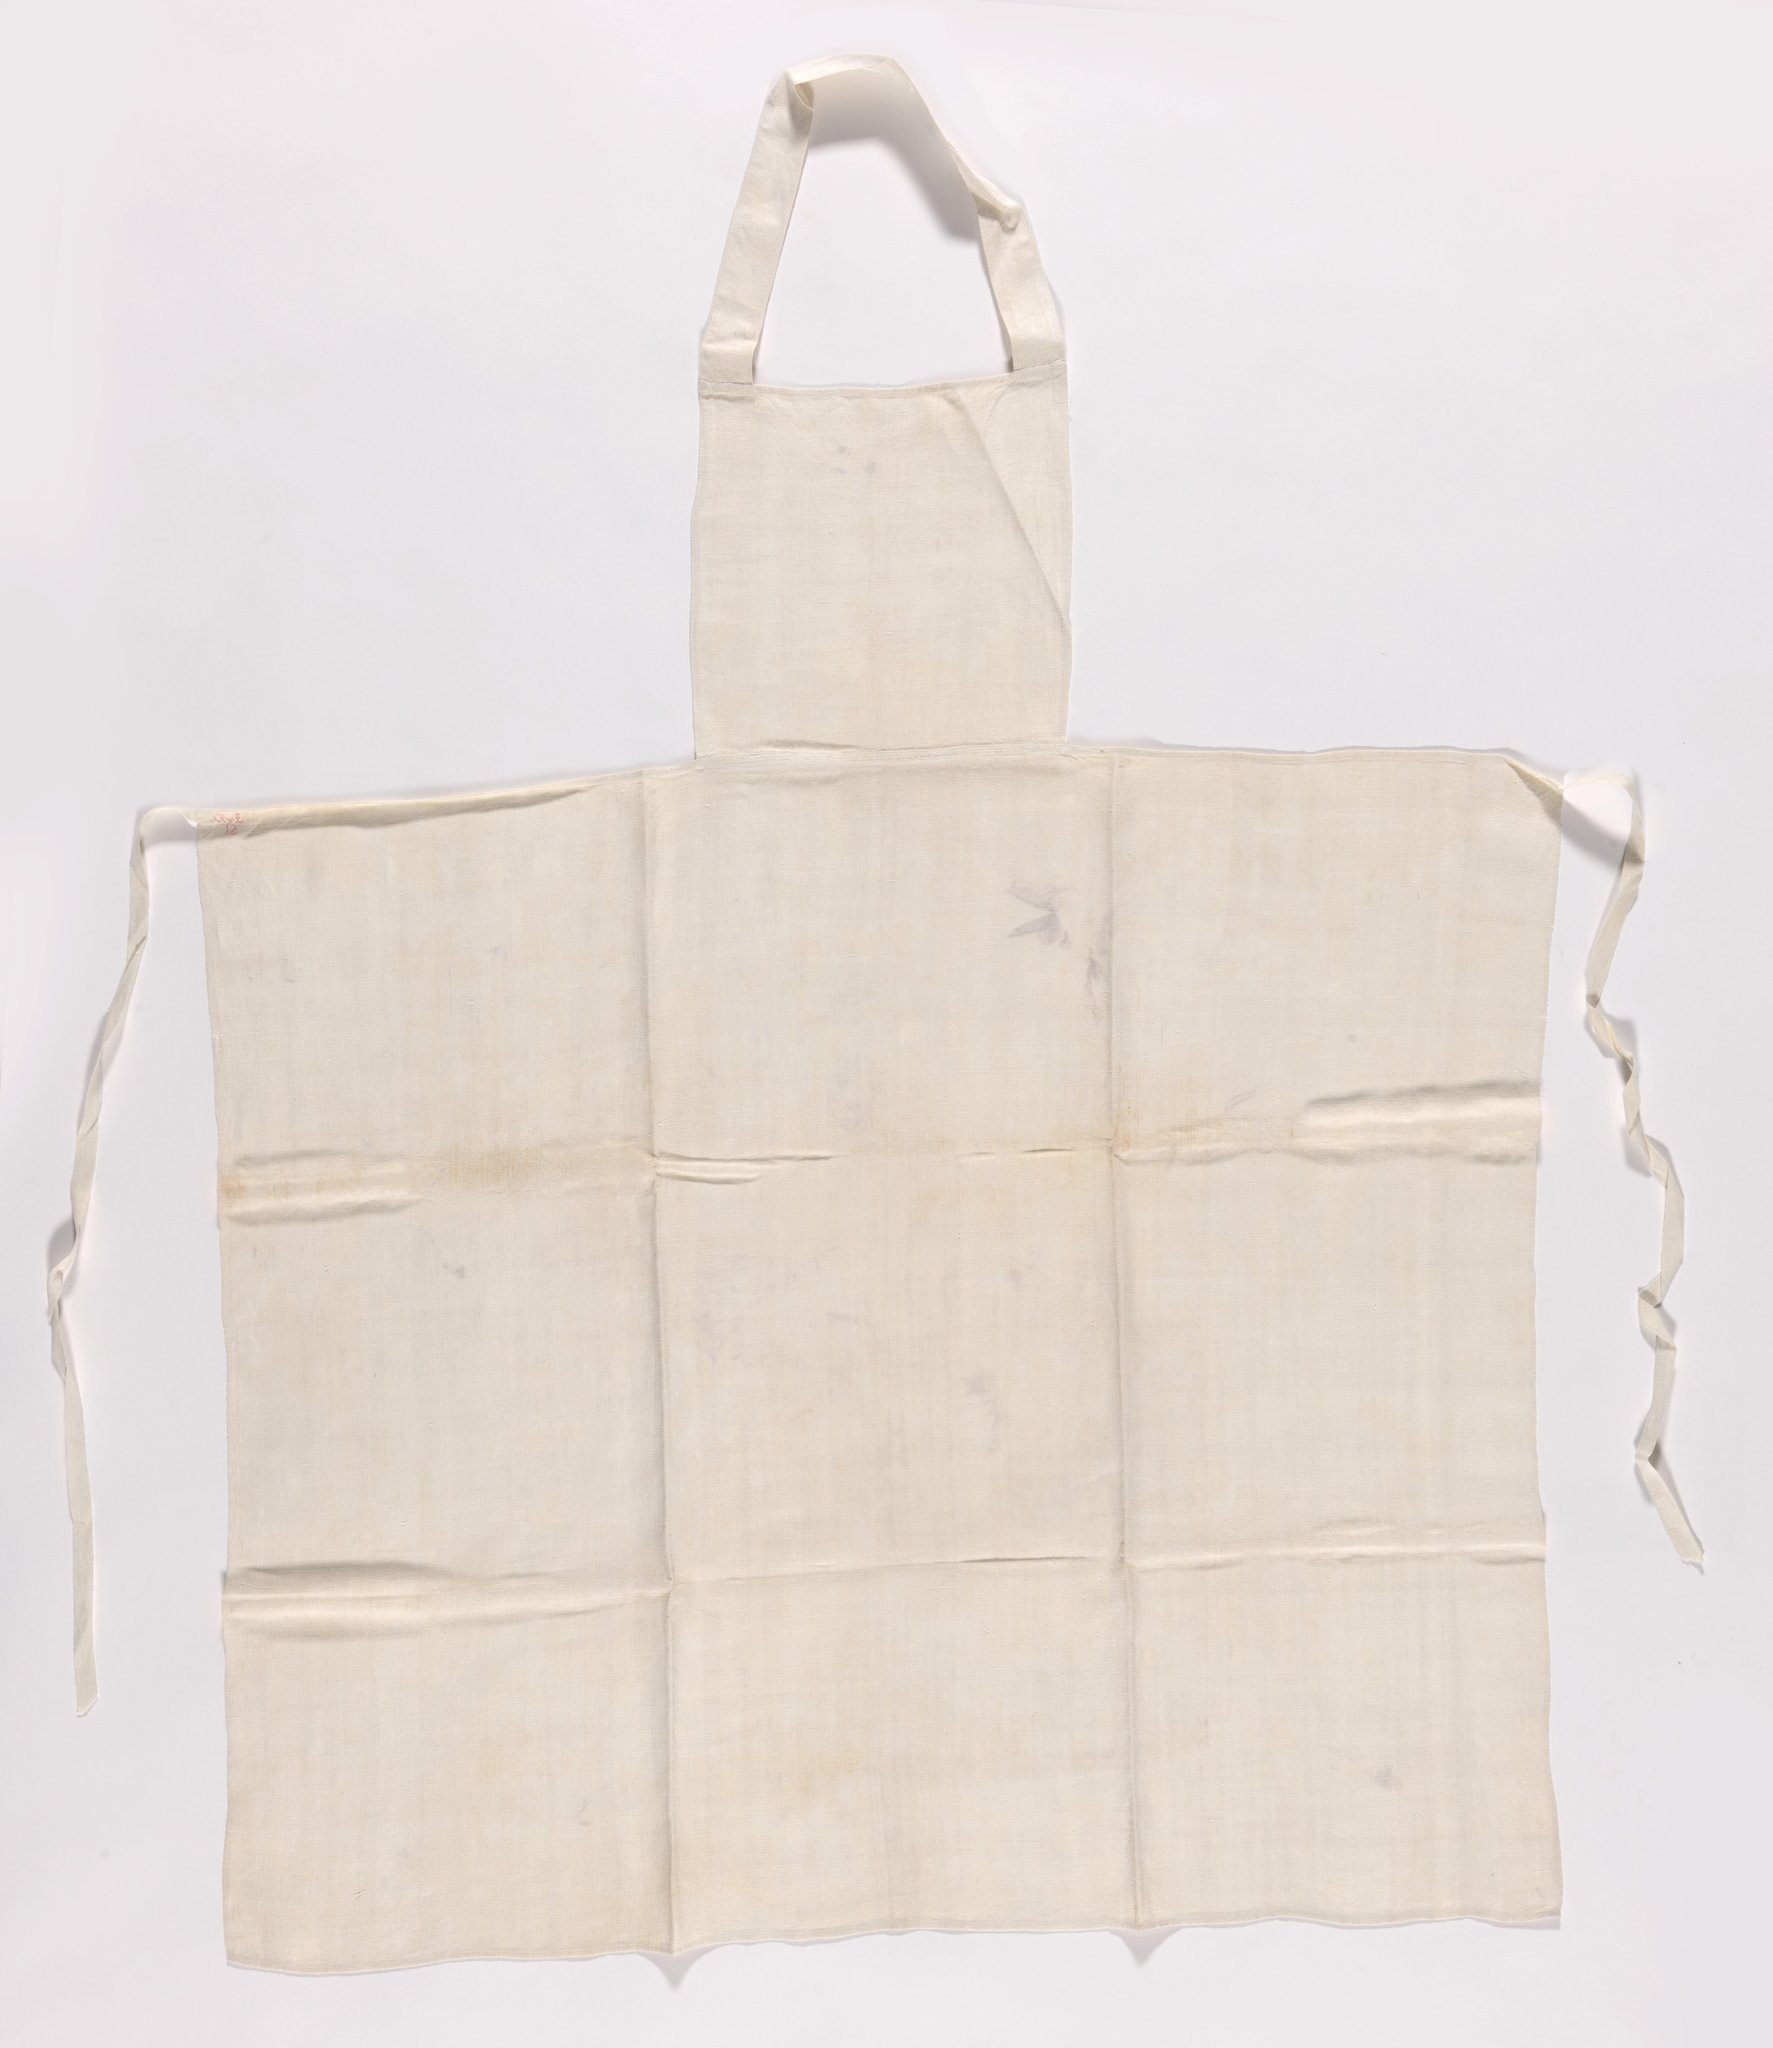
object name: apron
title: Schort geweven van ruw linnen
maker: Anonymous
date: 1400-1950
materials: linen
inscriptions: mark: ‘GvL 12’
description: Schort van ruw geweven linnen, bestaande uit een rechthoekige schoot en borststuk voorzien van een halsband en smallere, iets fijner geweven striklinten. Gemerkt in rode kruissteek: GvL 12 (Gevers van Lennep)